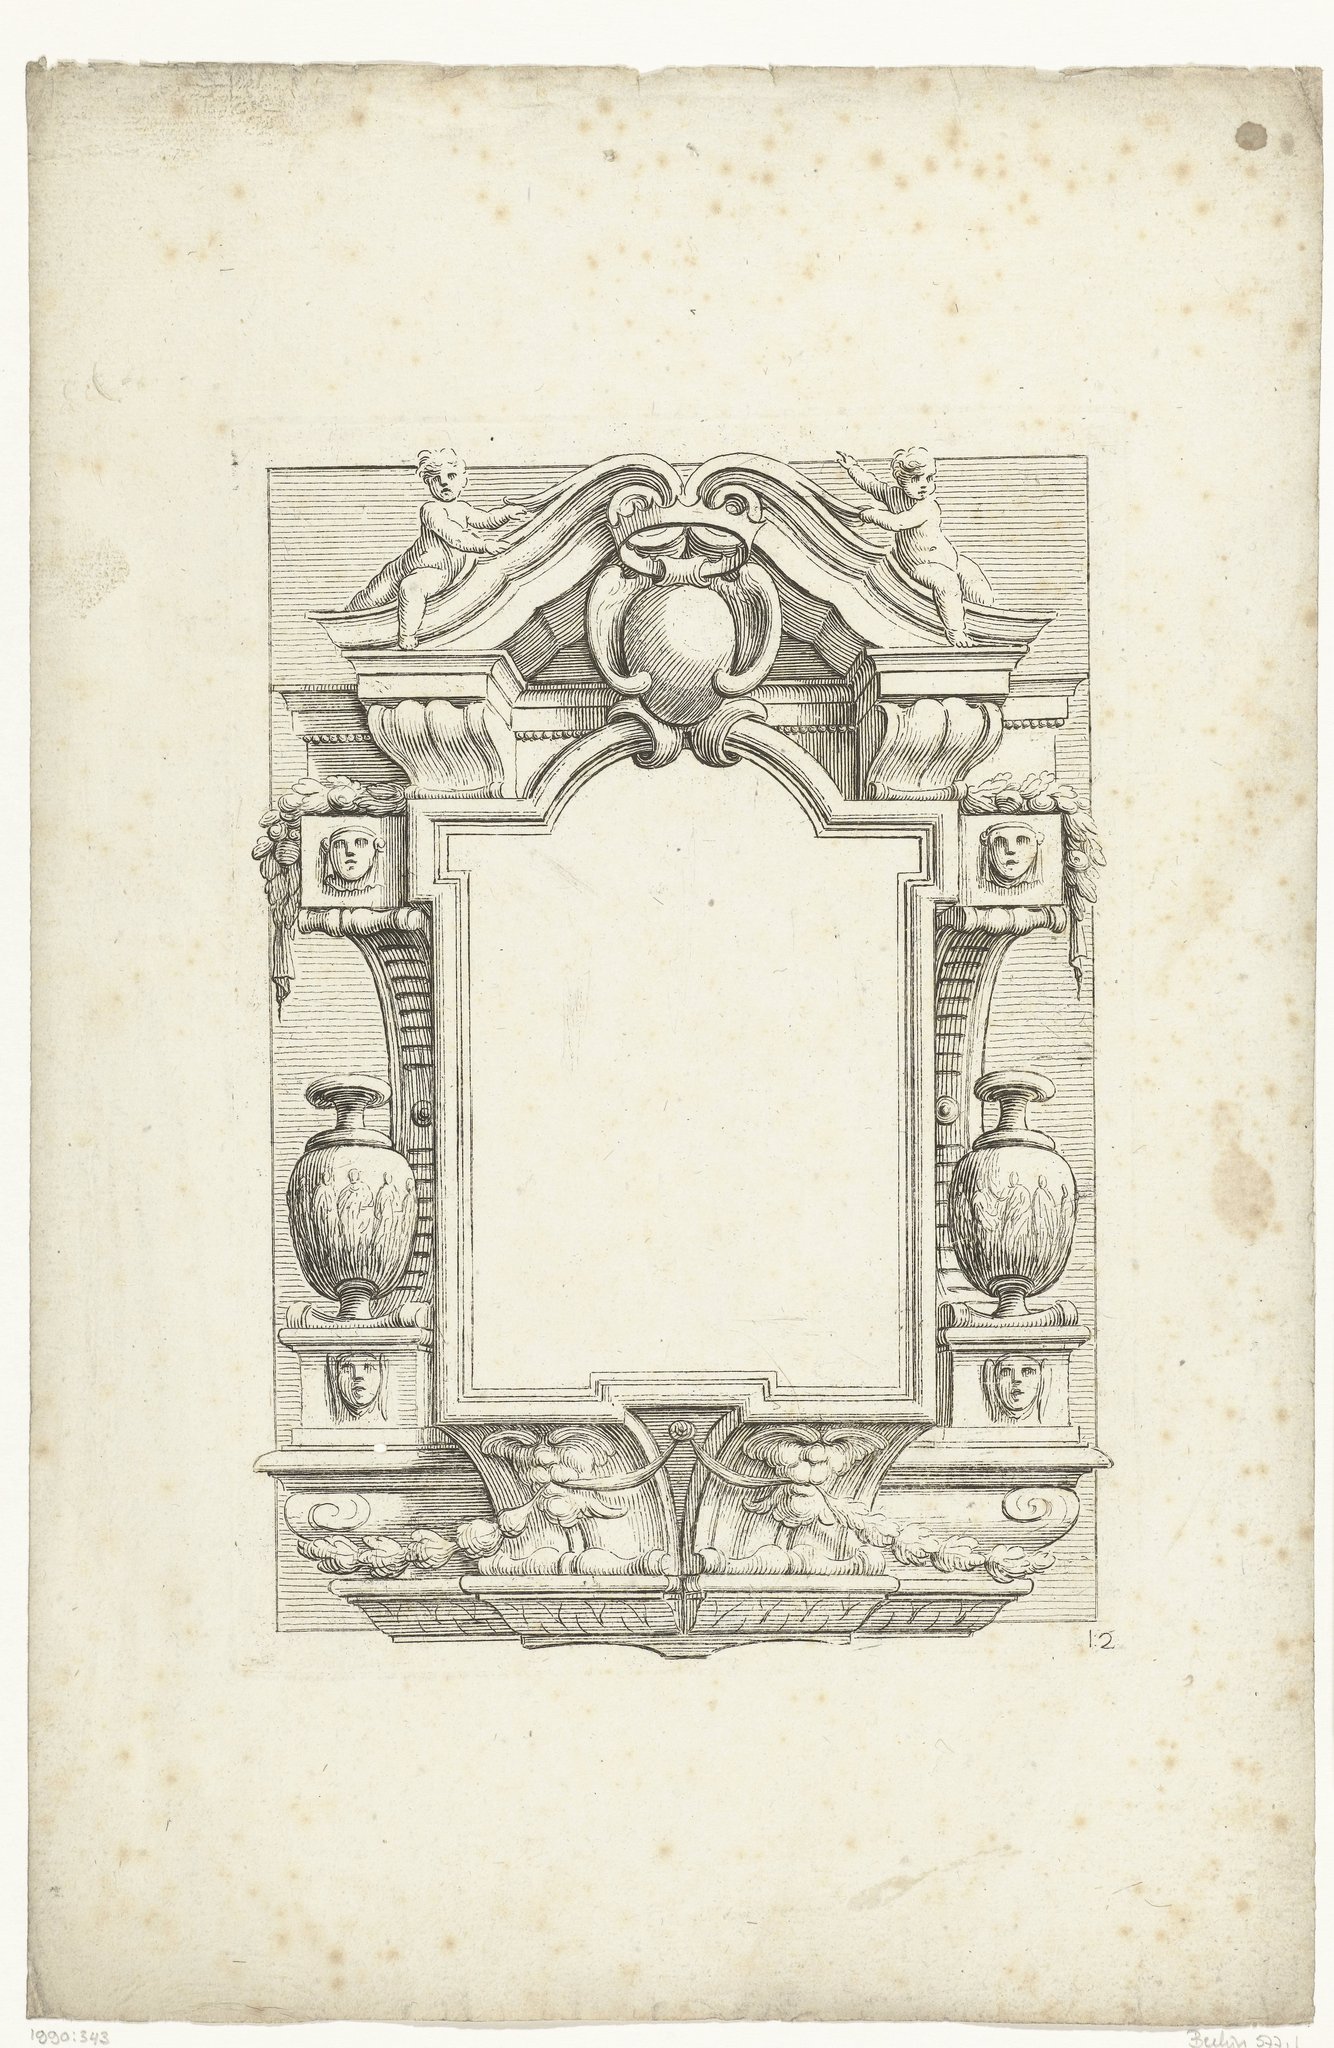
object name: print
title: Cartouches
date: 1670-1680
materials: paper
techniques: etching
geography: bologna